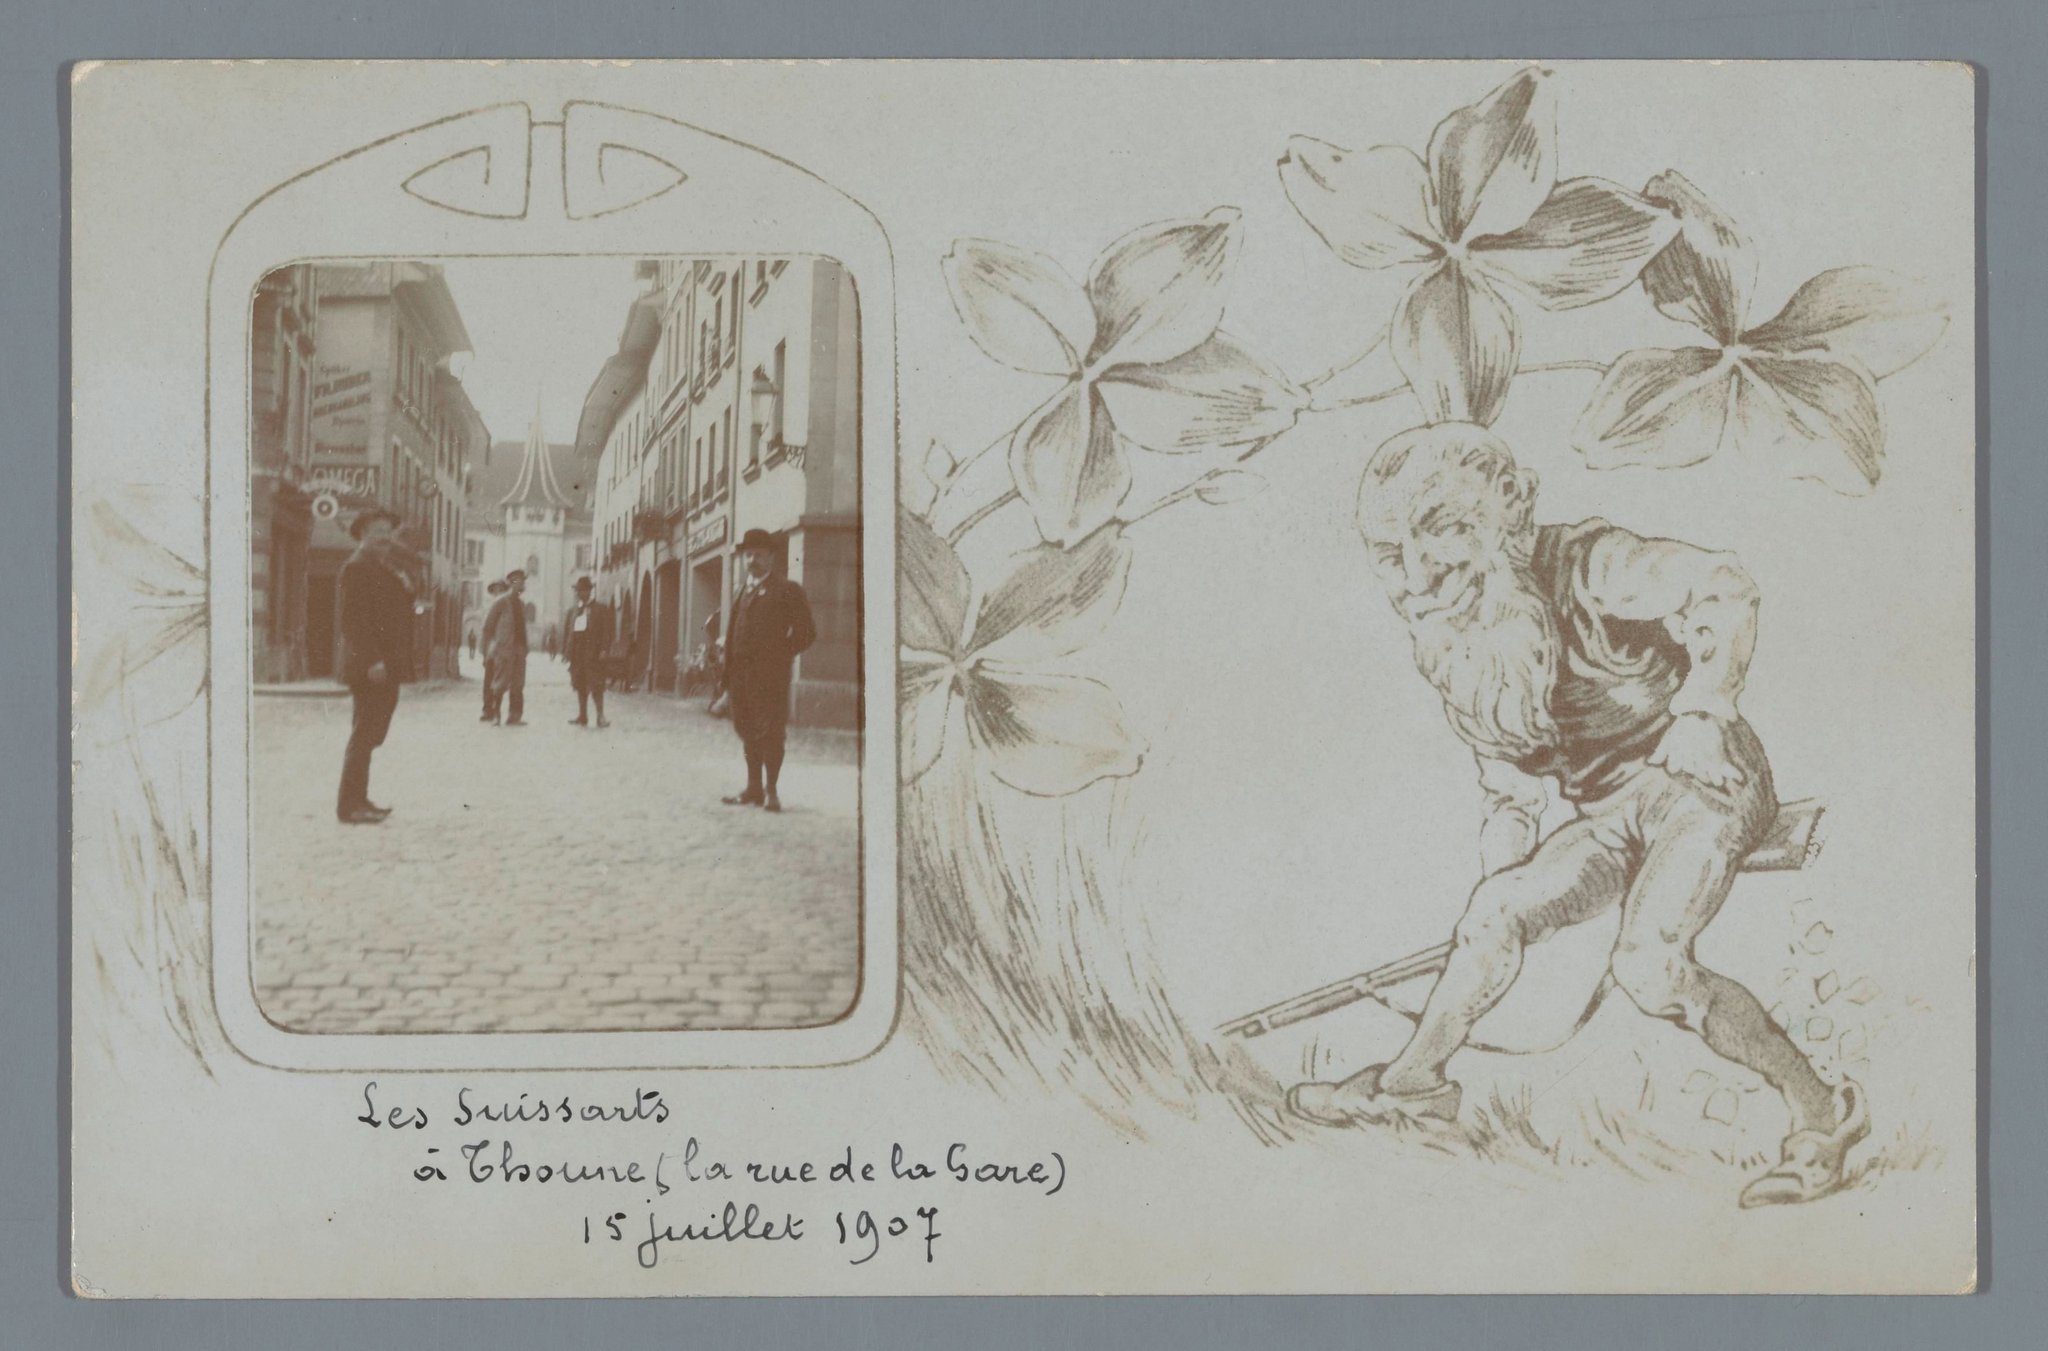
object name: photograph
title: Groepsportret van vijf onbekende mannen in de Rue de la Gare te Thun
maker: Anonymous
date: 1907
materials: photographic support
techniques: gelatin silver print, printing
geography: thun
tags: street, anonymous historical persons portrayed in a group, in a group-portrait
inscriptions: inscription: ‘Les Suissarts à Thoune (la rue de la Gare)’